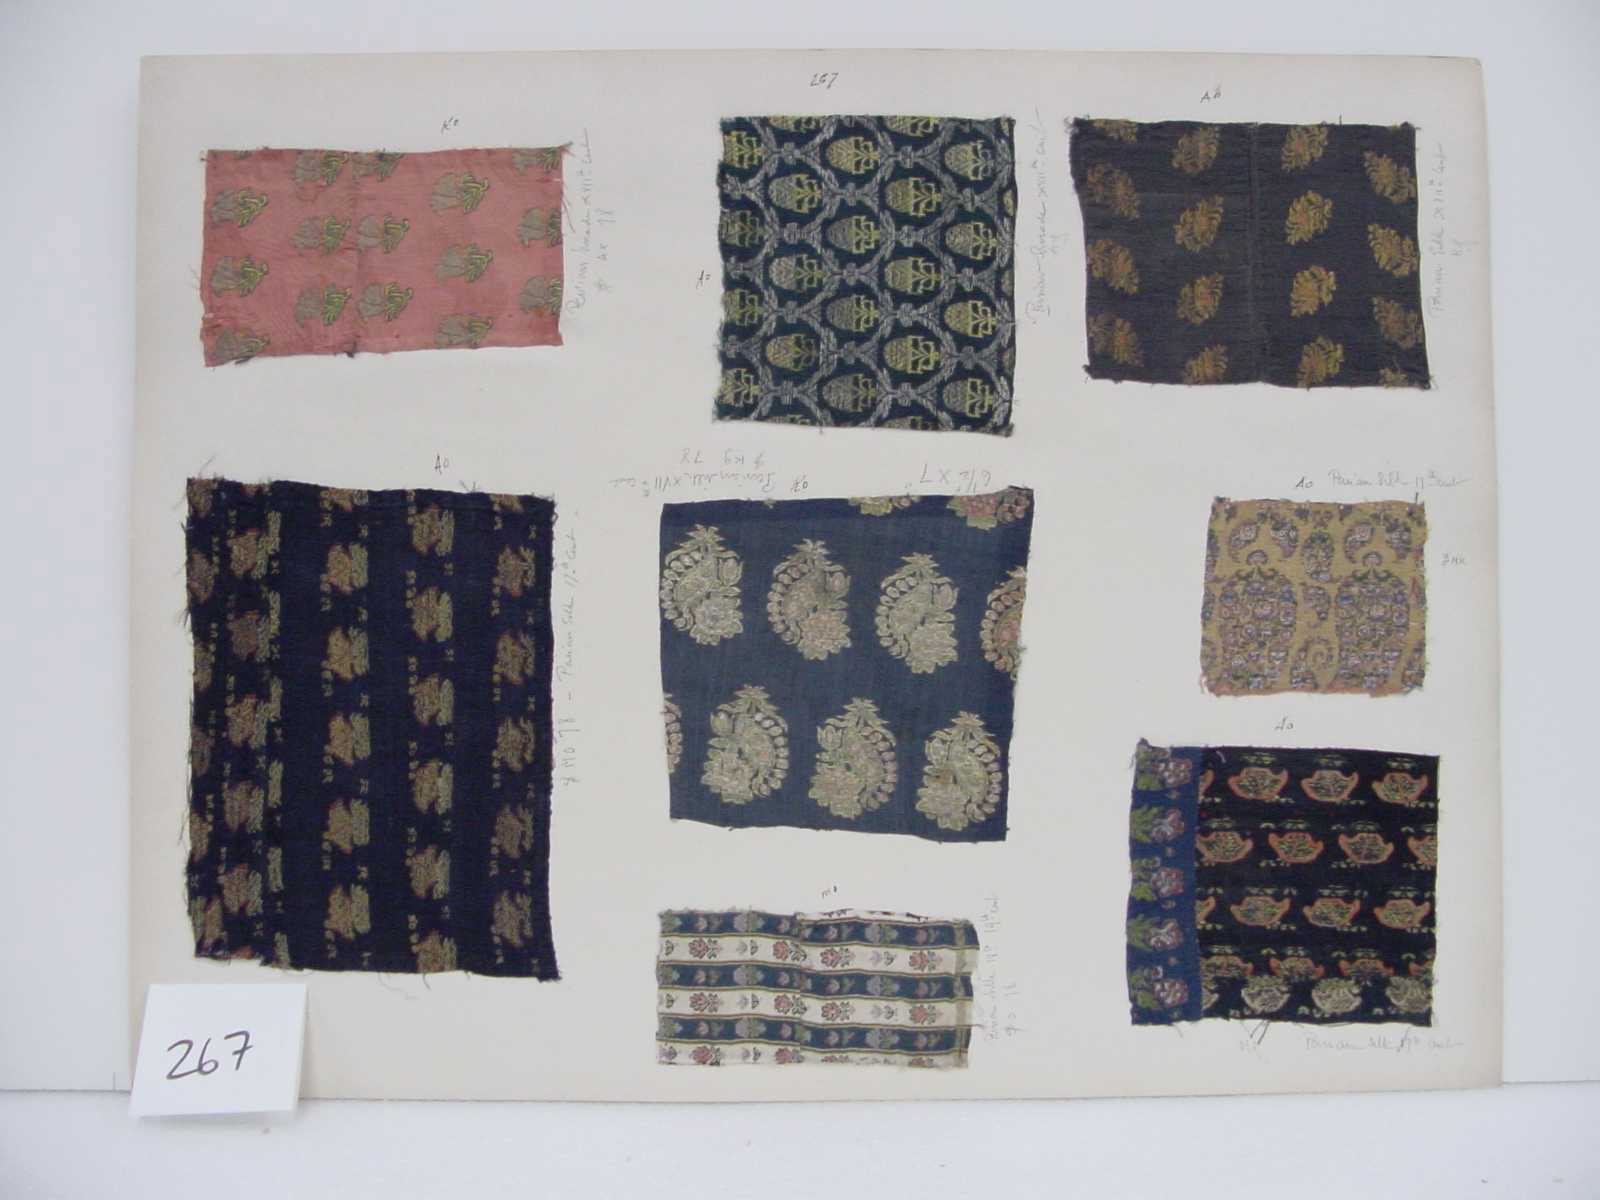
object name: textile fragment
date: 1601-1800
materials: metal thread, silk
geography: iran